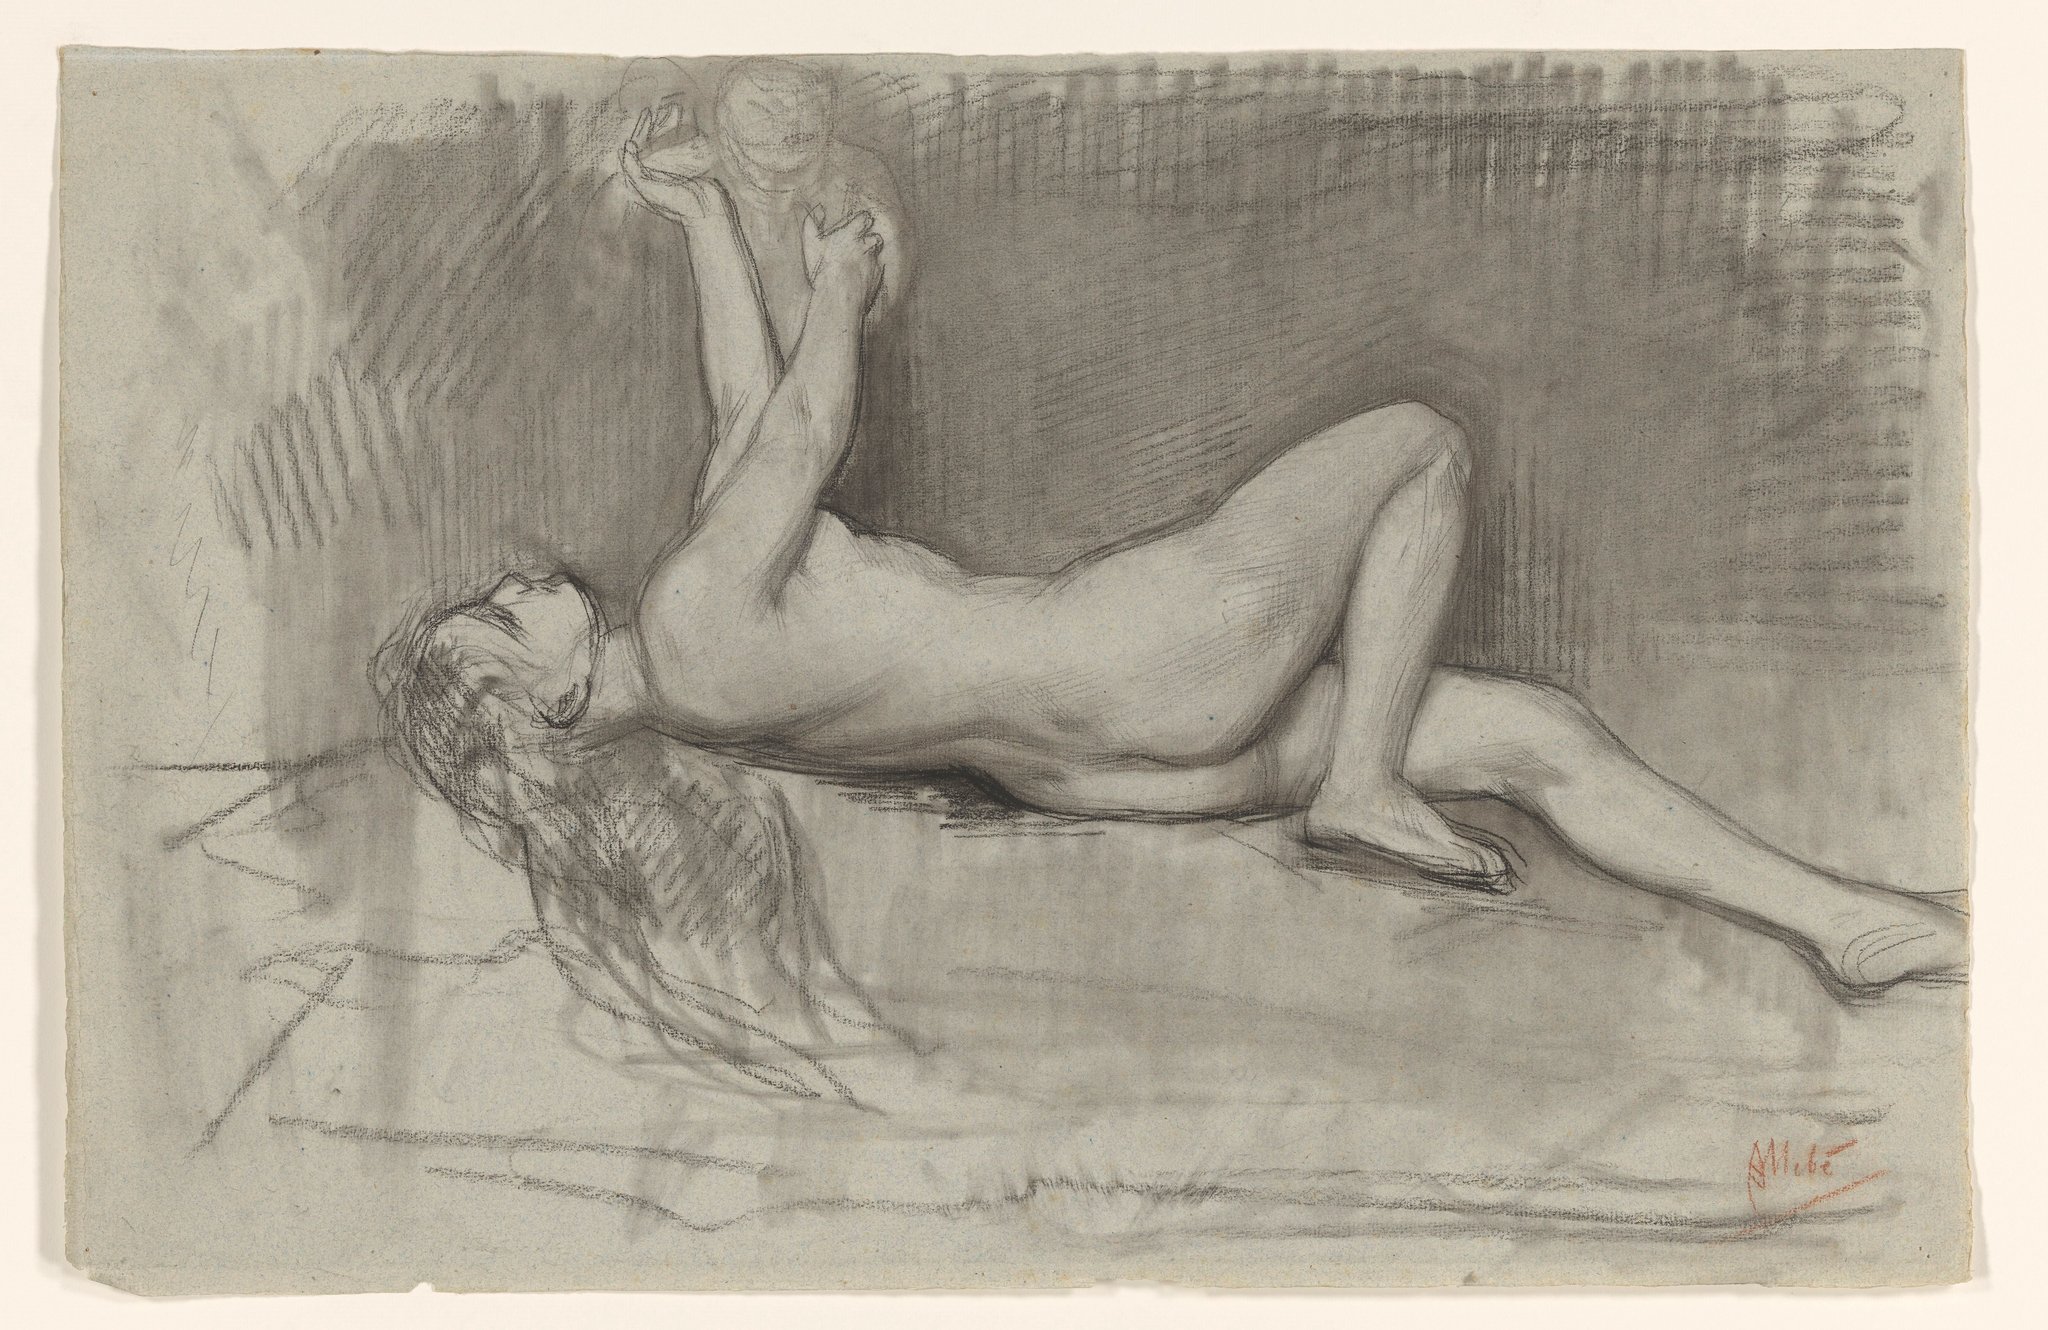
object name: drawing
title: Naaktstudie van achteroverliggende vrouw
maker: august allebé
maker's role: draughtsman, print maker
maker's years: 1838-1927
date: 1848-1927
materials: chalk, paper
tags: lying figure - aa - female human figure (+ nude human being)